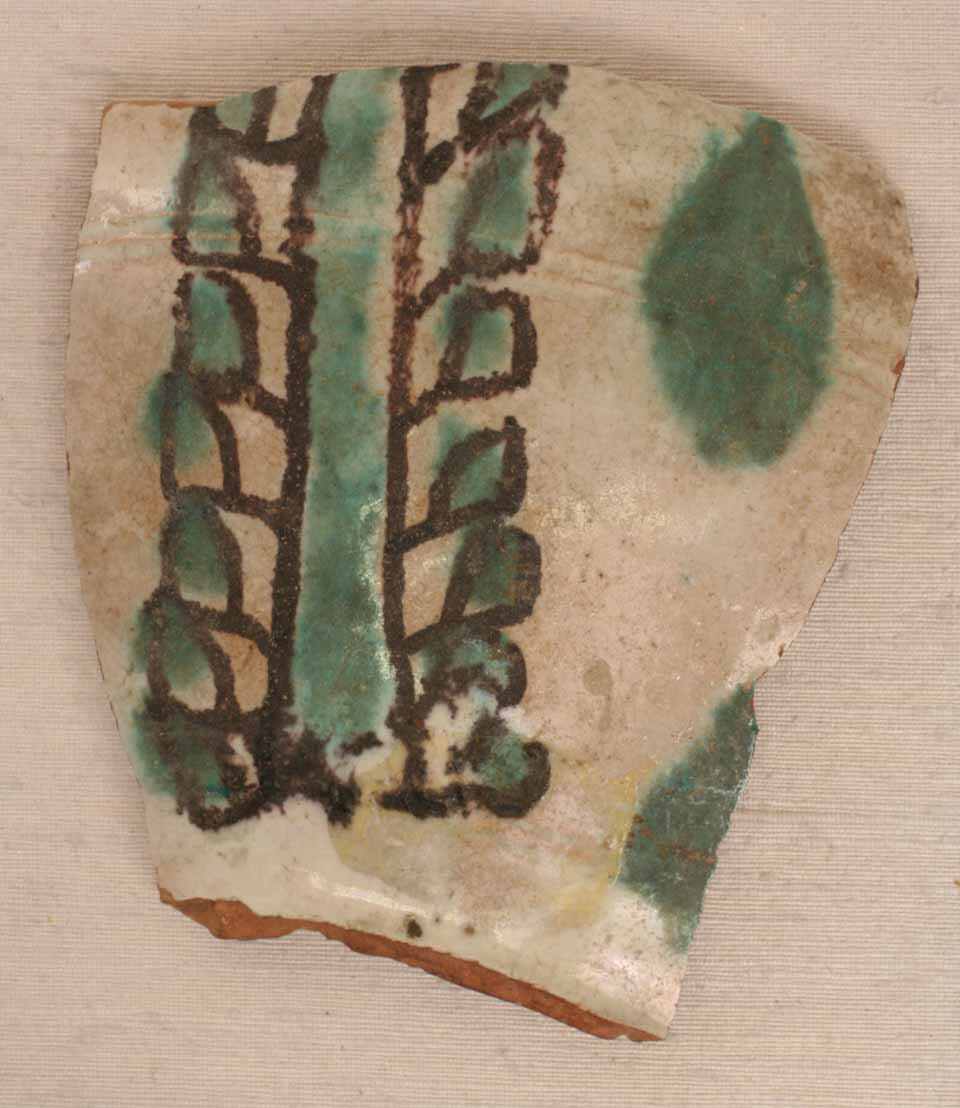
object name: fragment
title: Fragment of a Jar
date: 801-900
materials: earthenware, glaze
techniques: polychrome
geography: iran